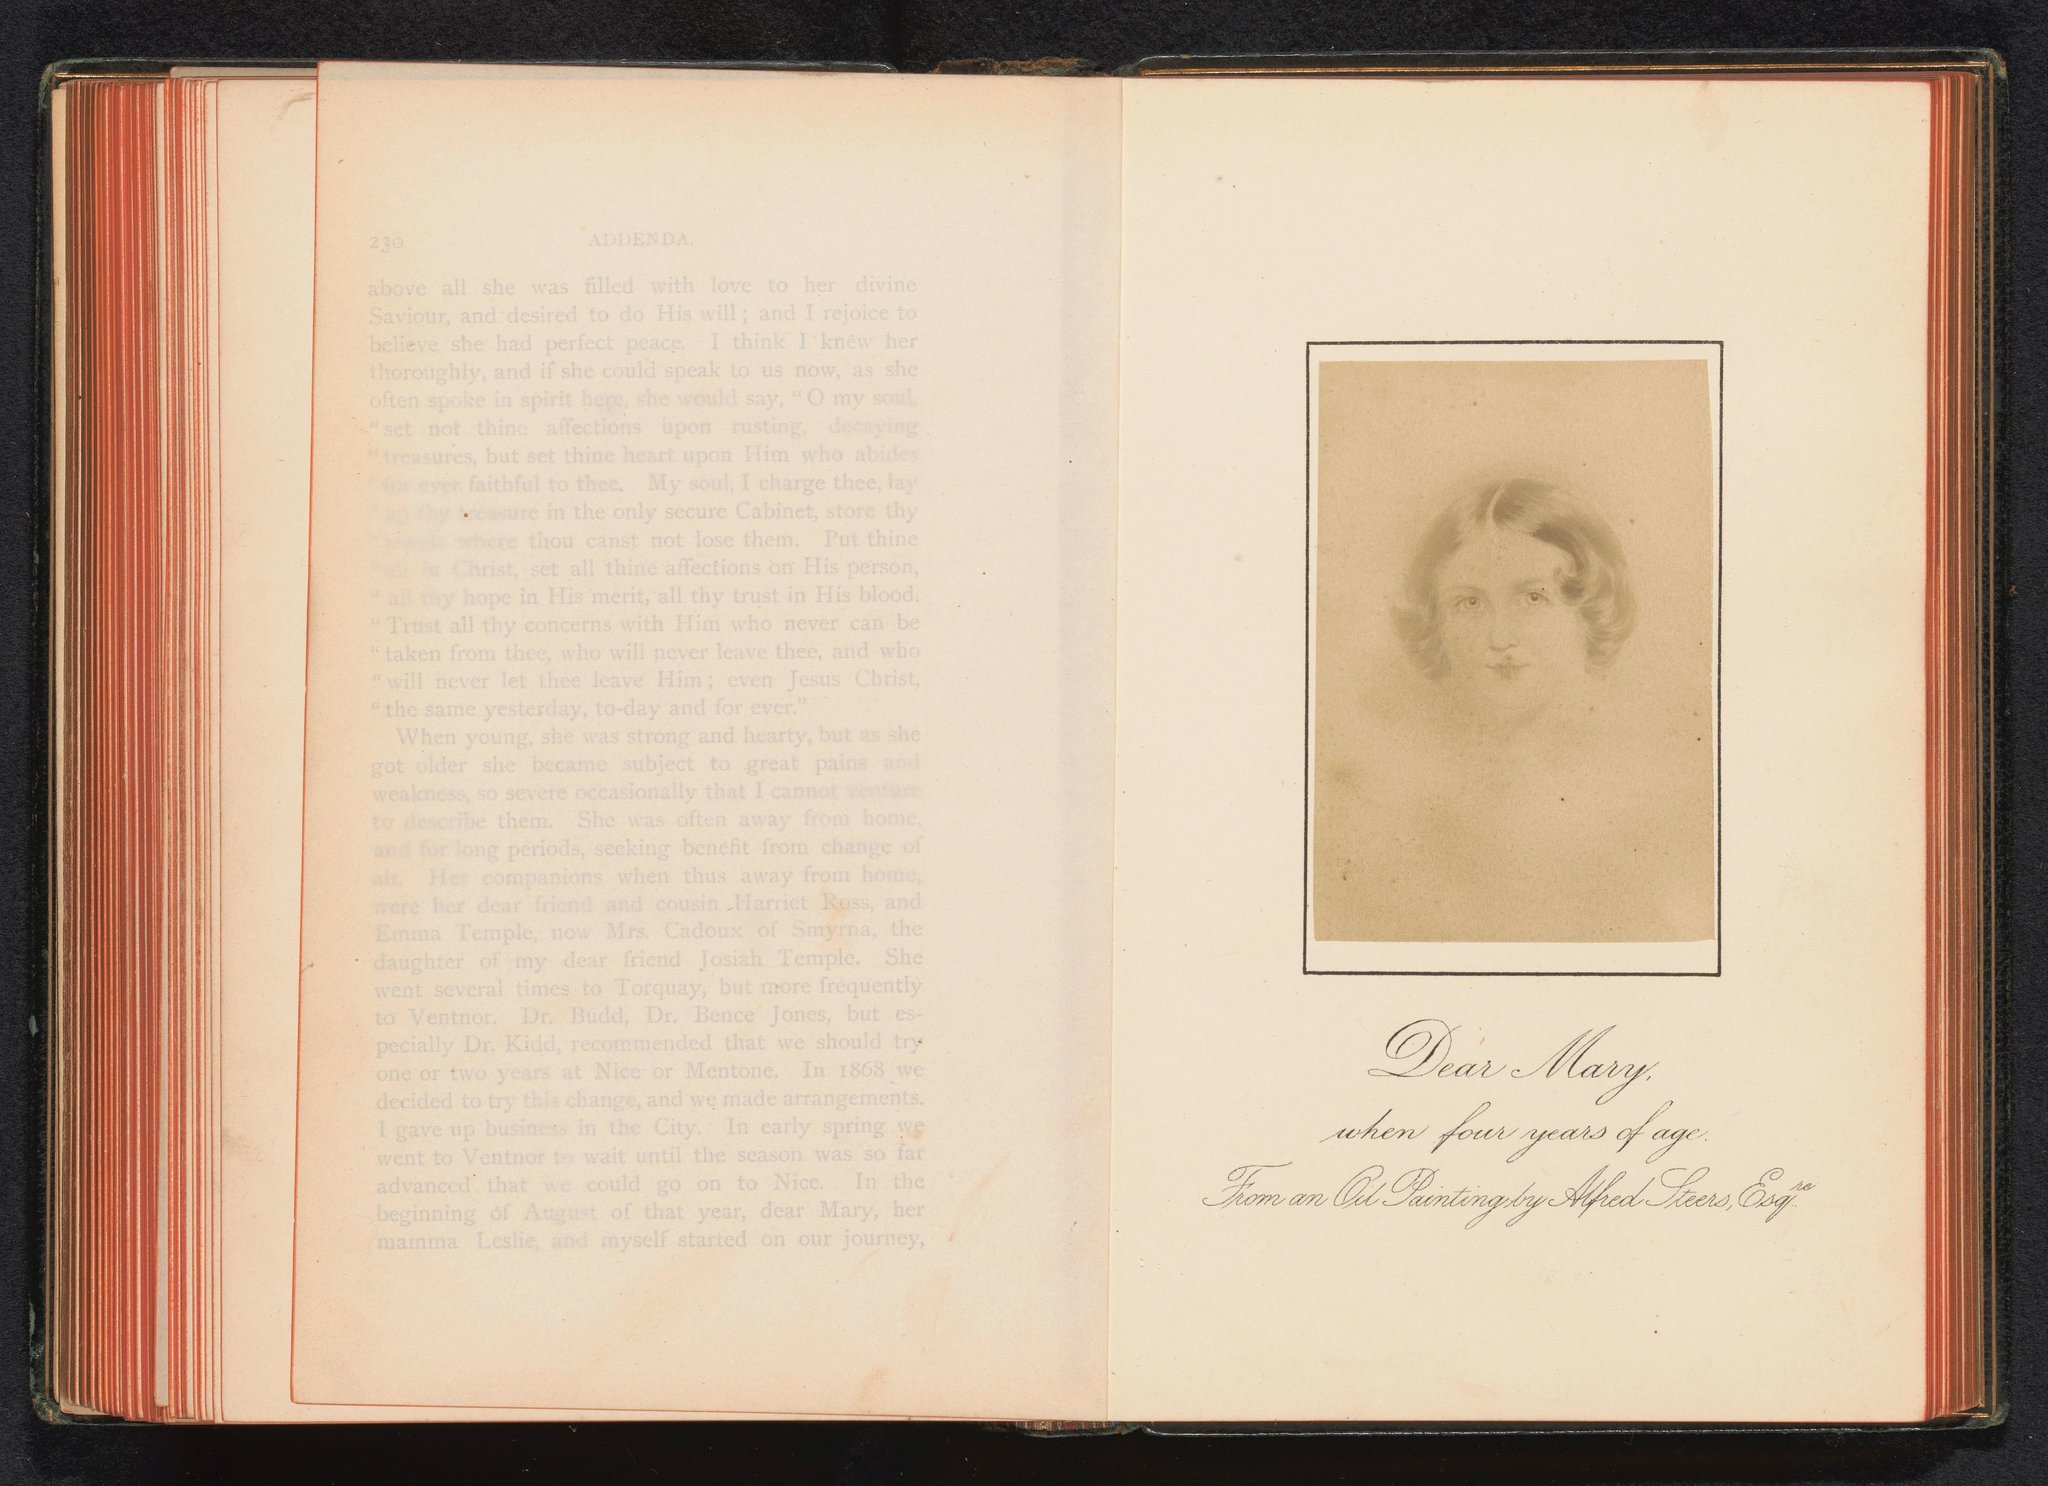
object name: photograph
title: Dear Mary, when four years of age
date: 1872-1882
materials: photographic support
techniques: albumen print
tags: historical persons - bb - woman, child (at home) - aa - girl